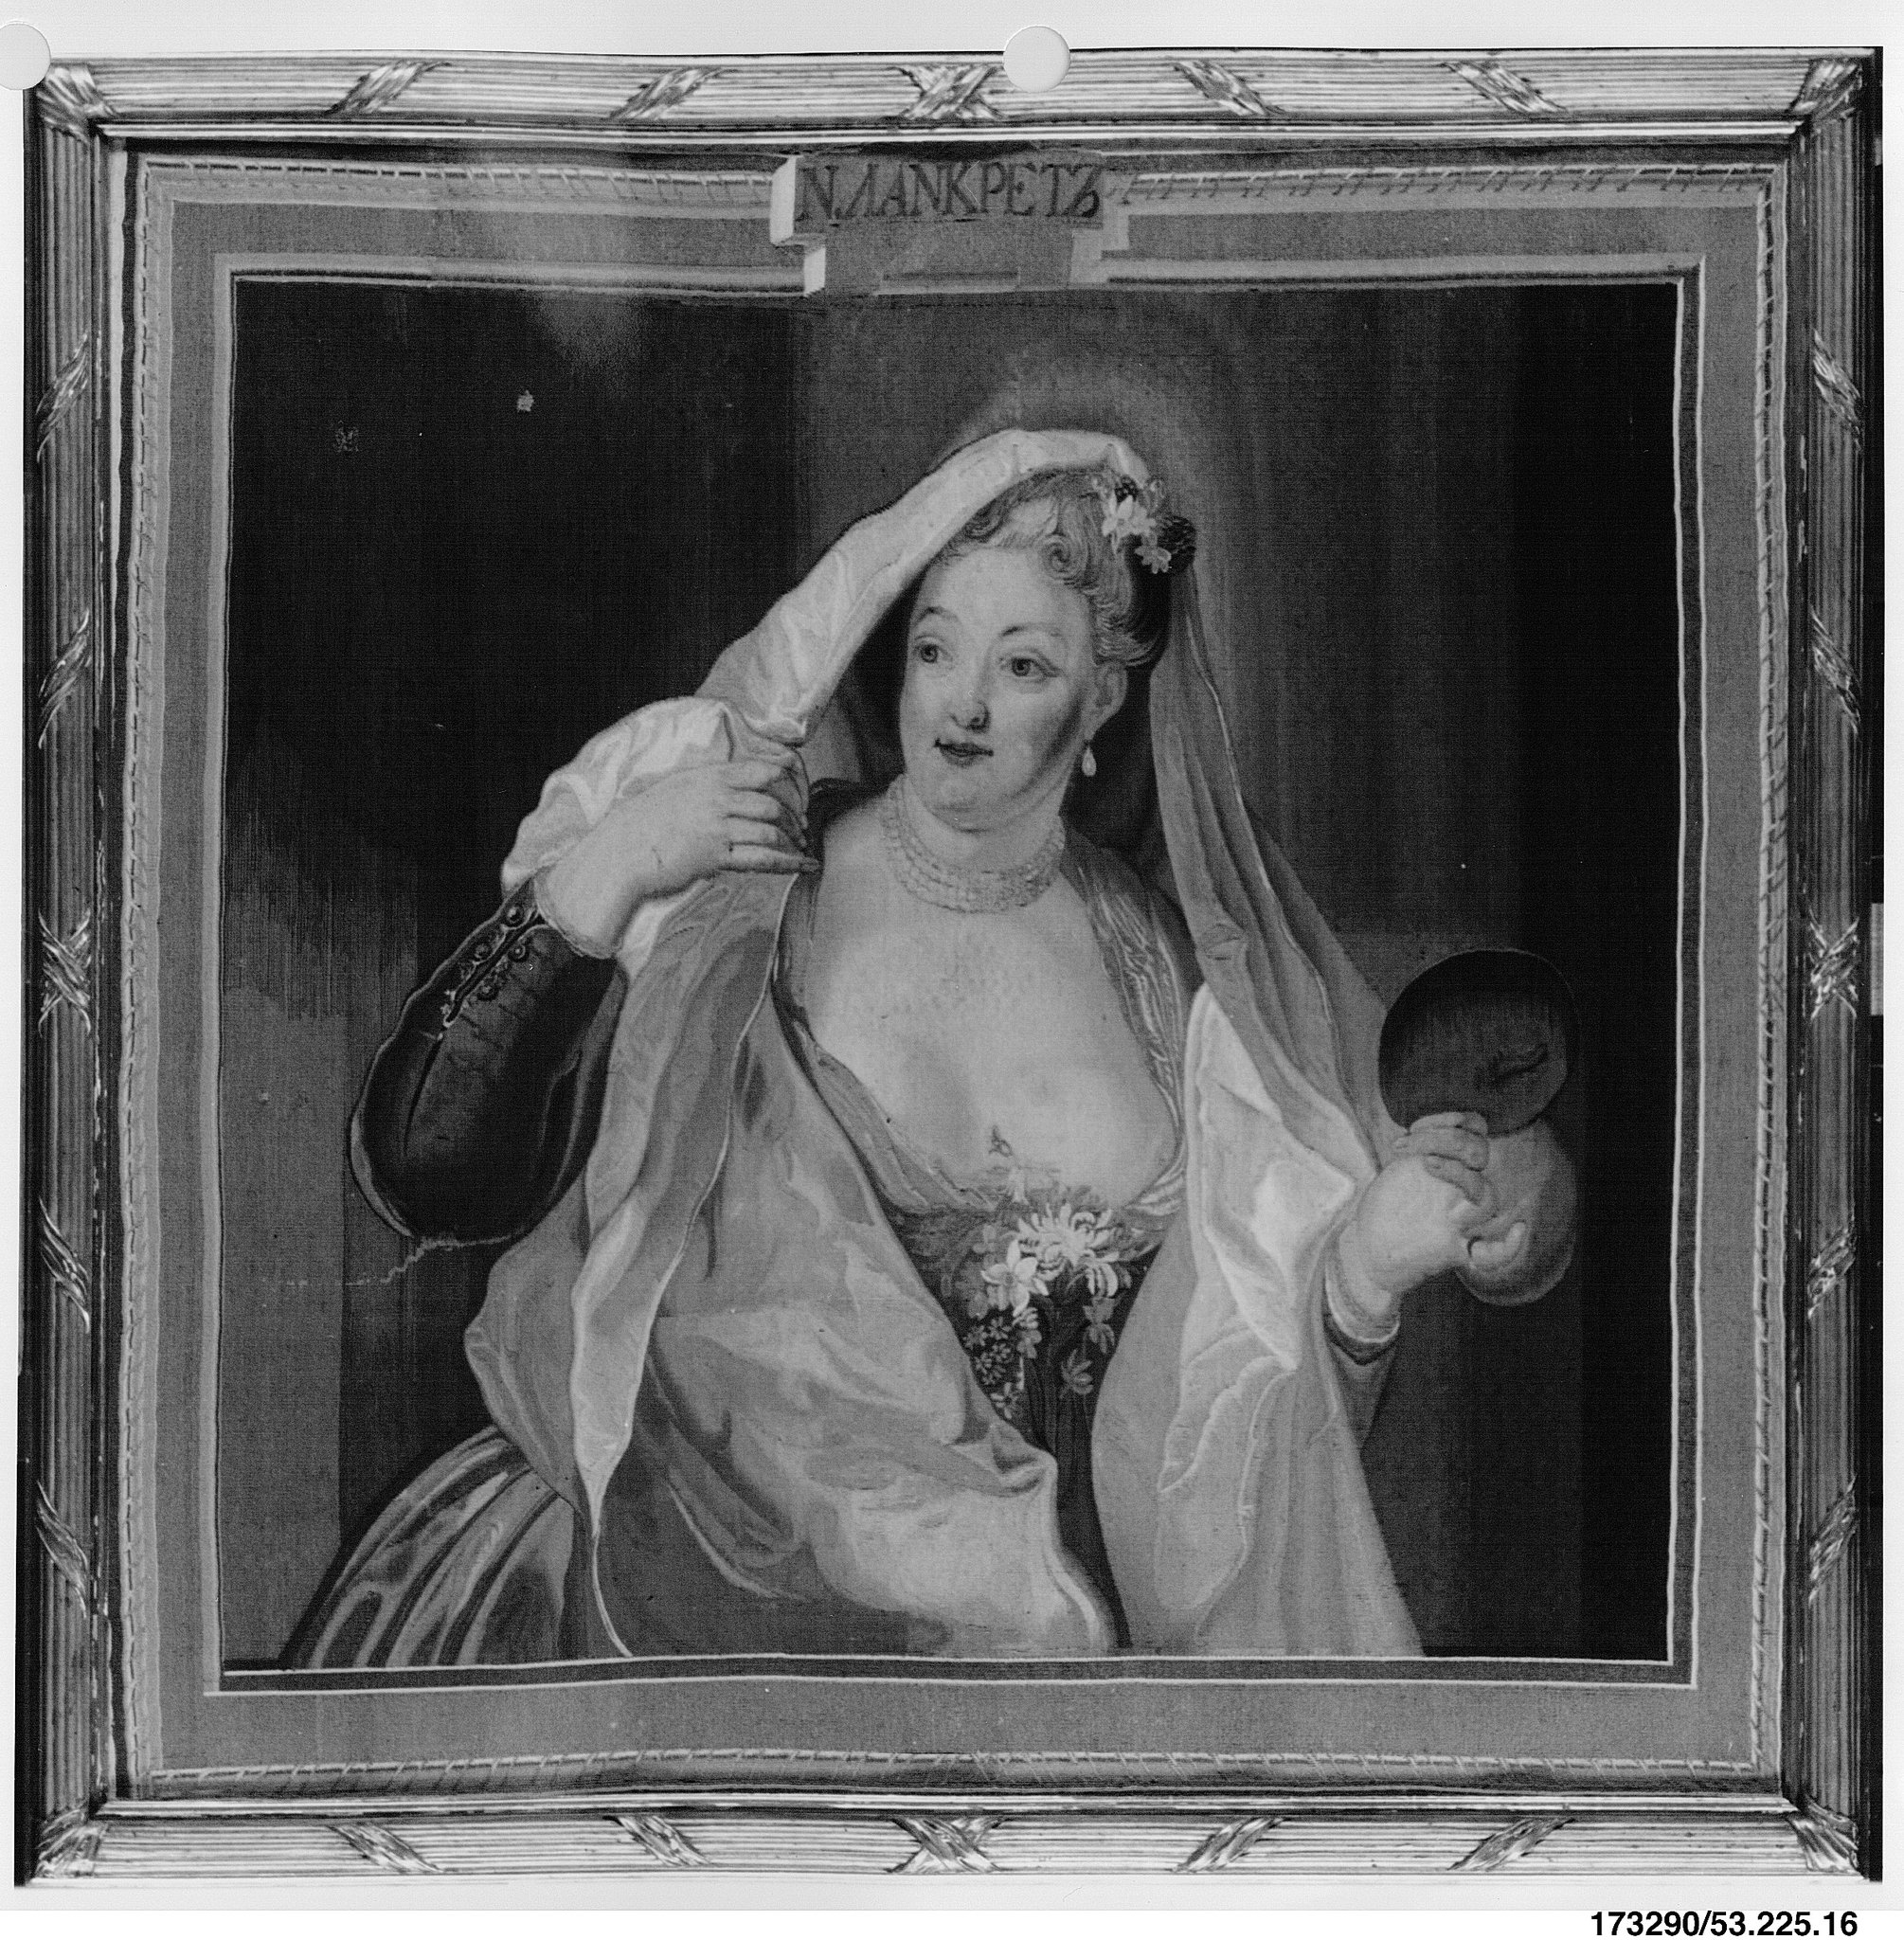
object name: tapestry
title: Woman with a Mirror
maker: imperial russian tapestry manufactory, saint petersburg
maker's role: manufactory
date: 1767-1800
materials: metal thread, wool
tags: portraits,women,mirrors